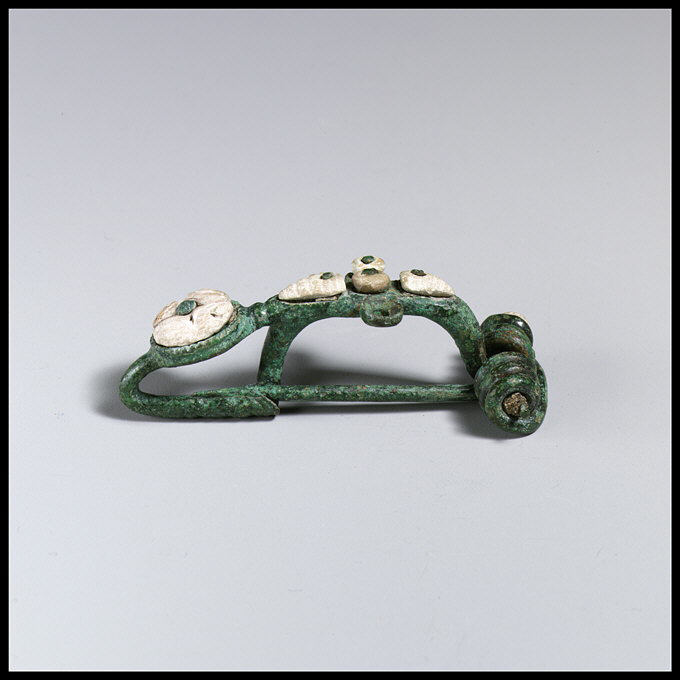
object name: fibula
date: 7000 BCE-330 CE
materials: bronze